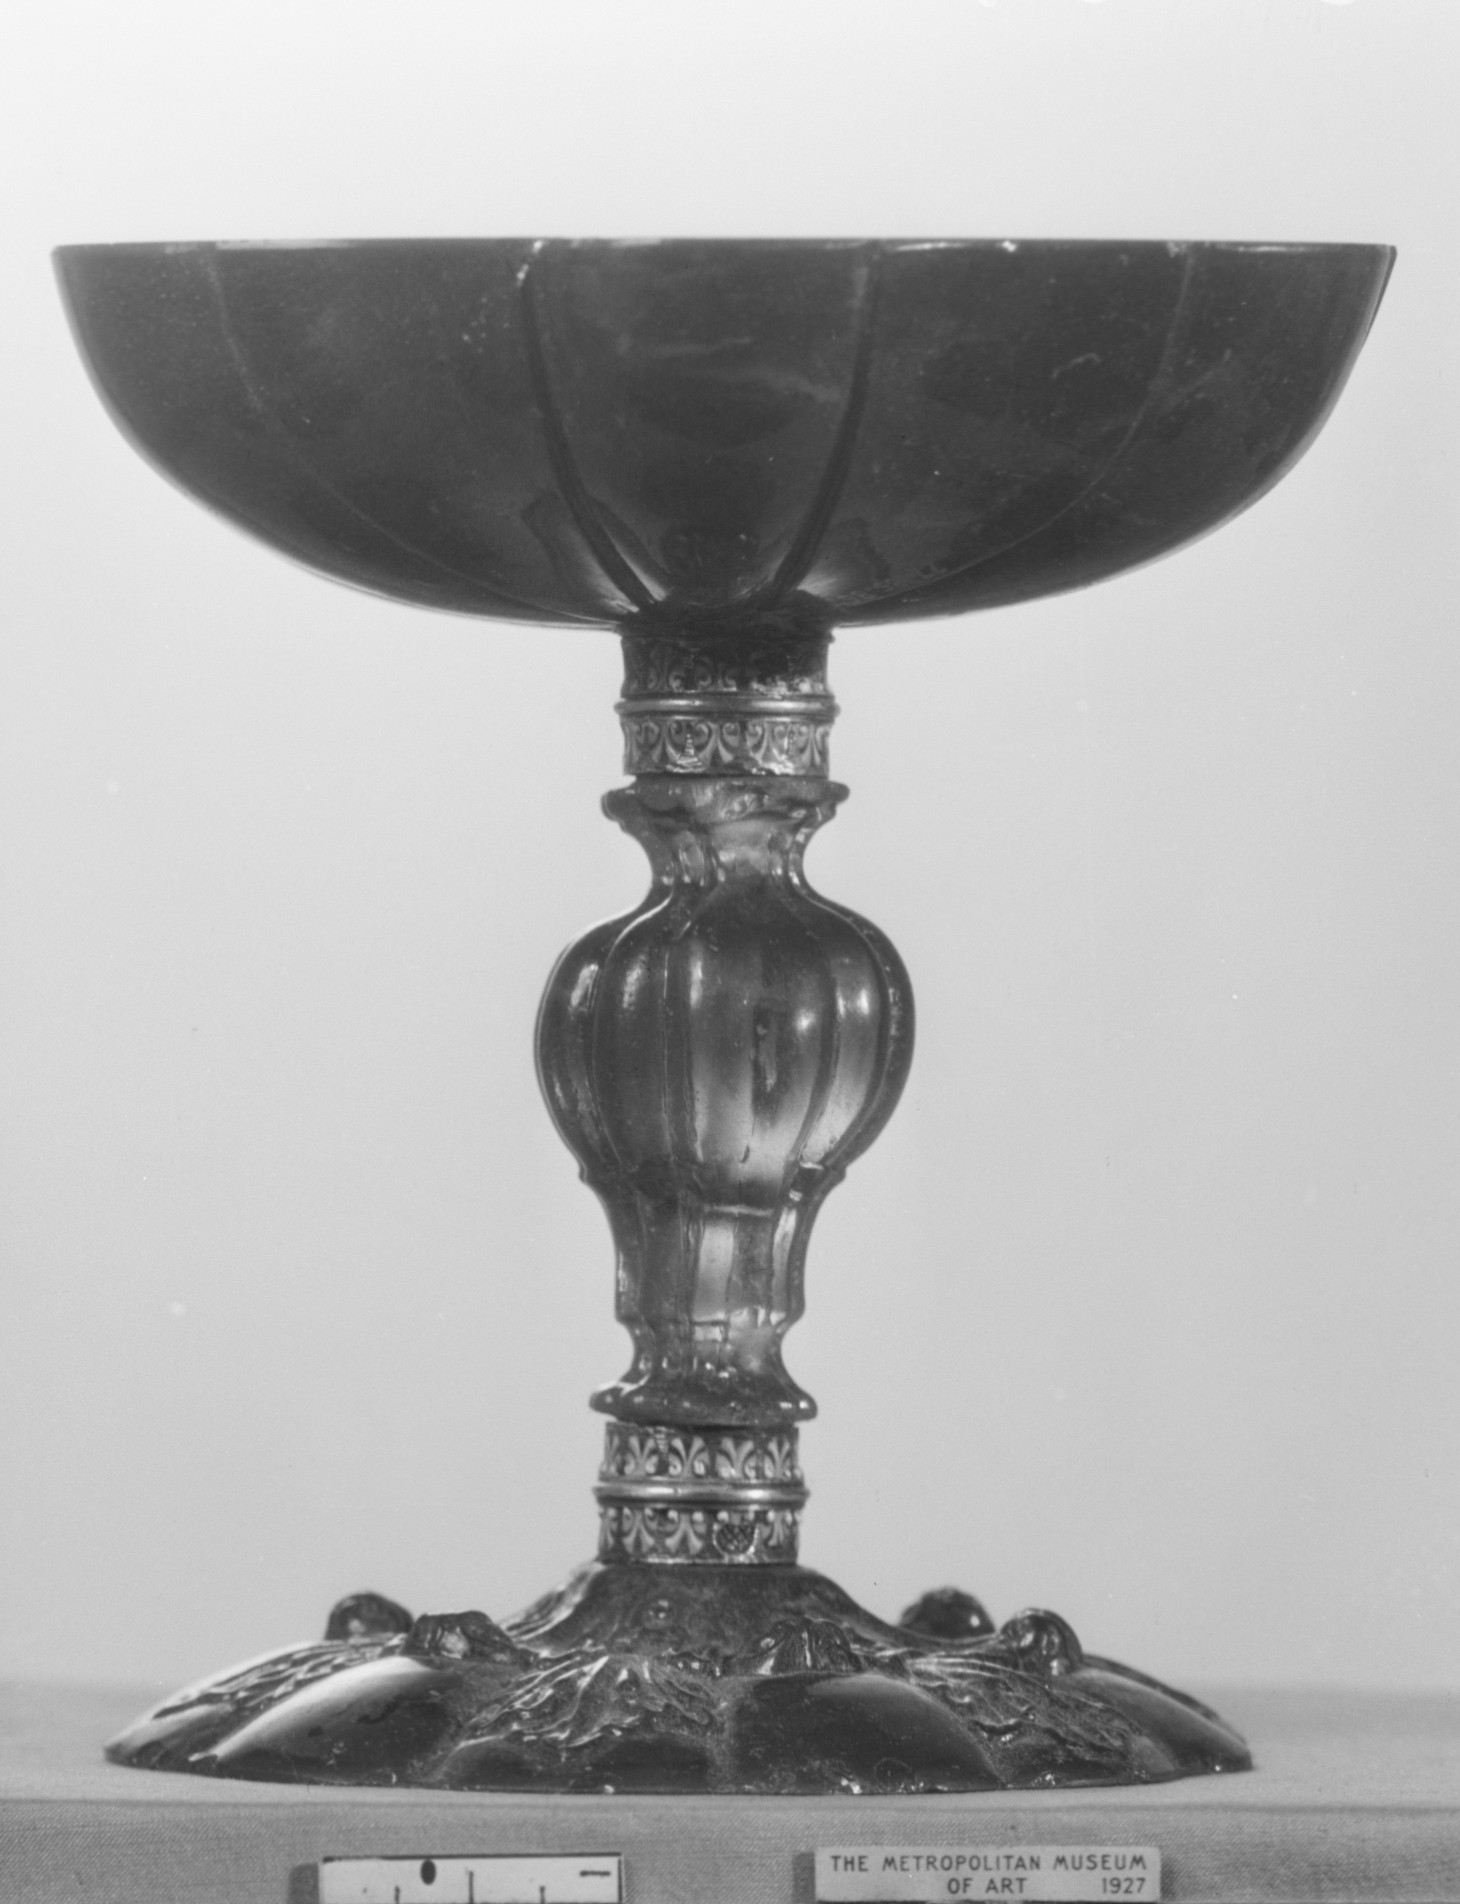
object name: sweetmeat glass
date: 1667-1733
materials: glass, silver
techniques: enamel